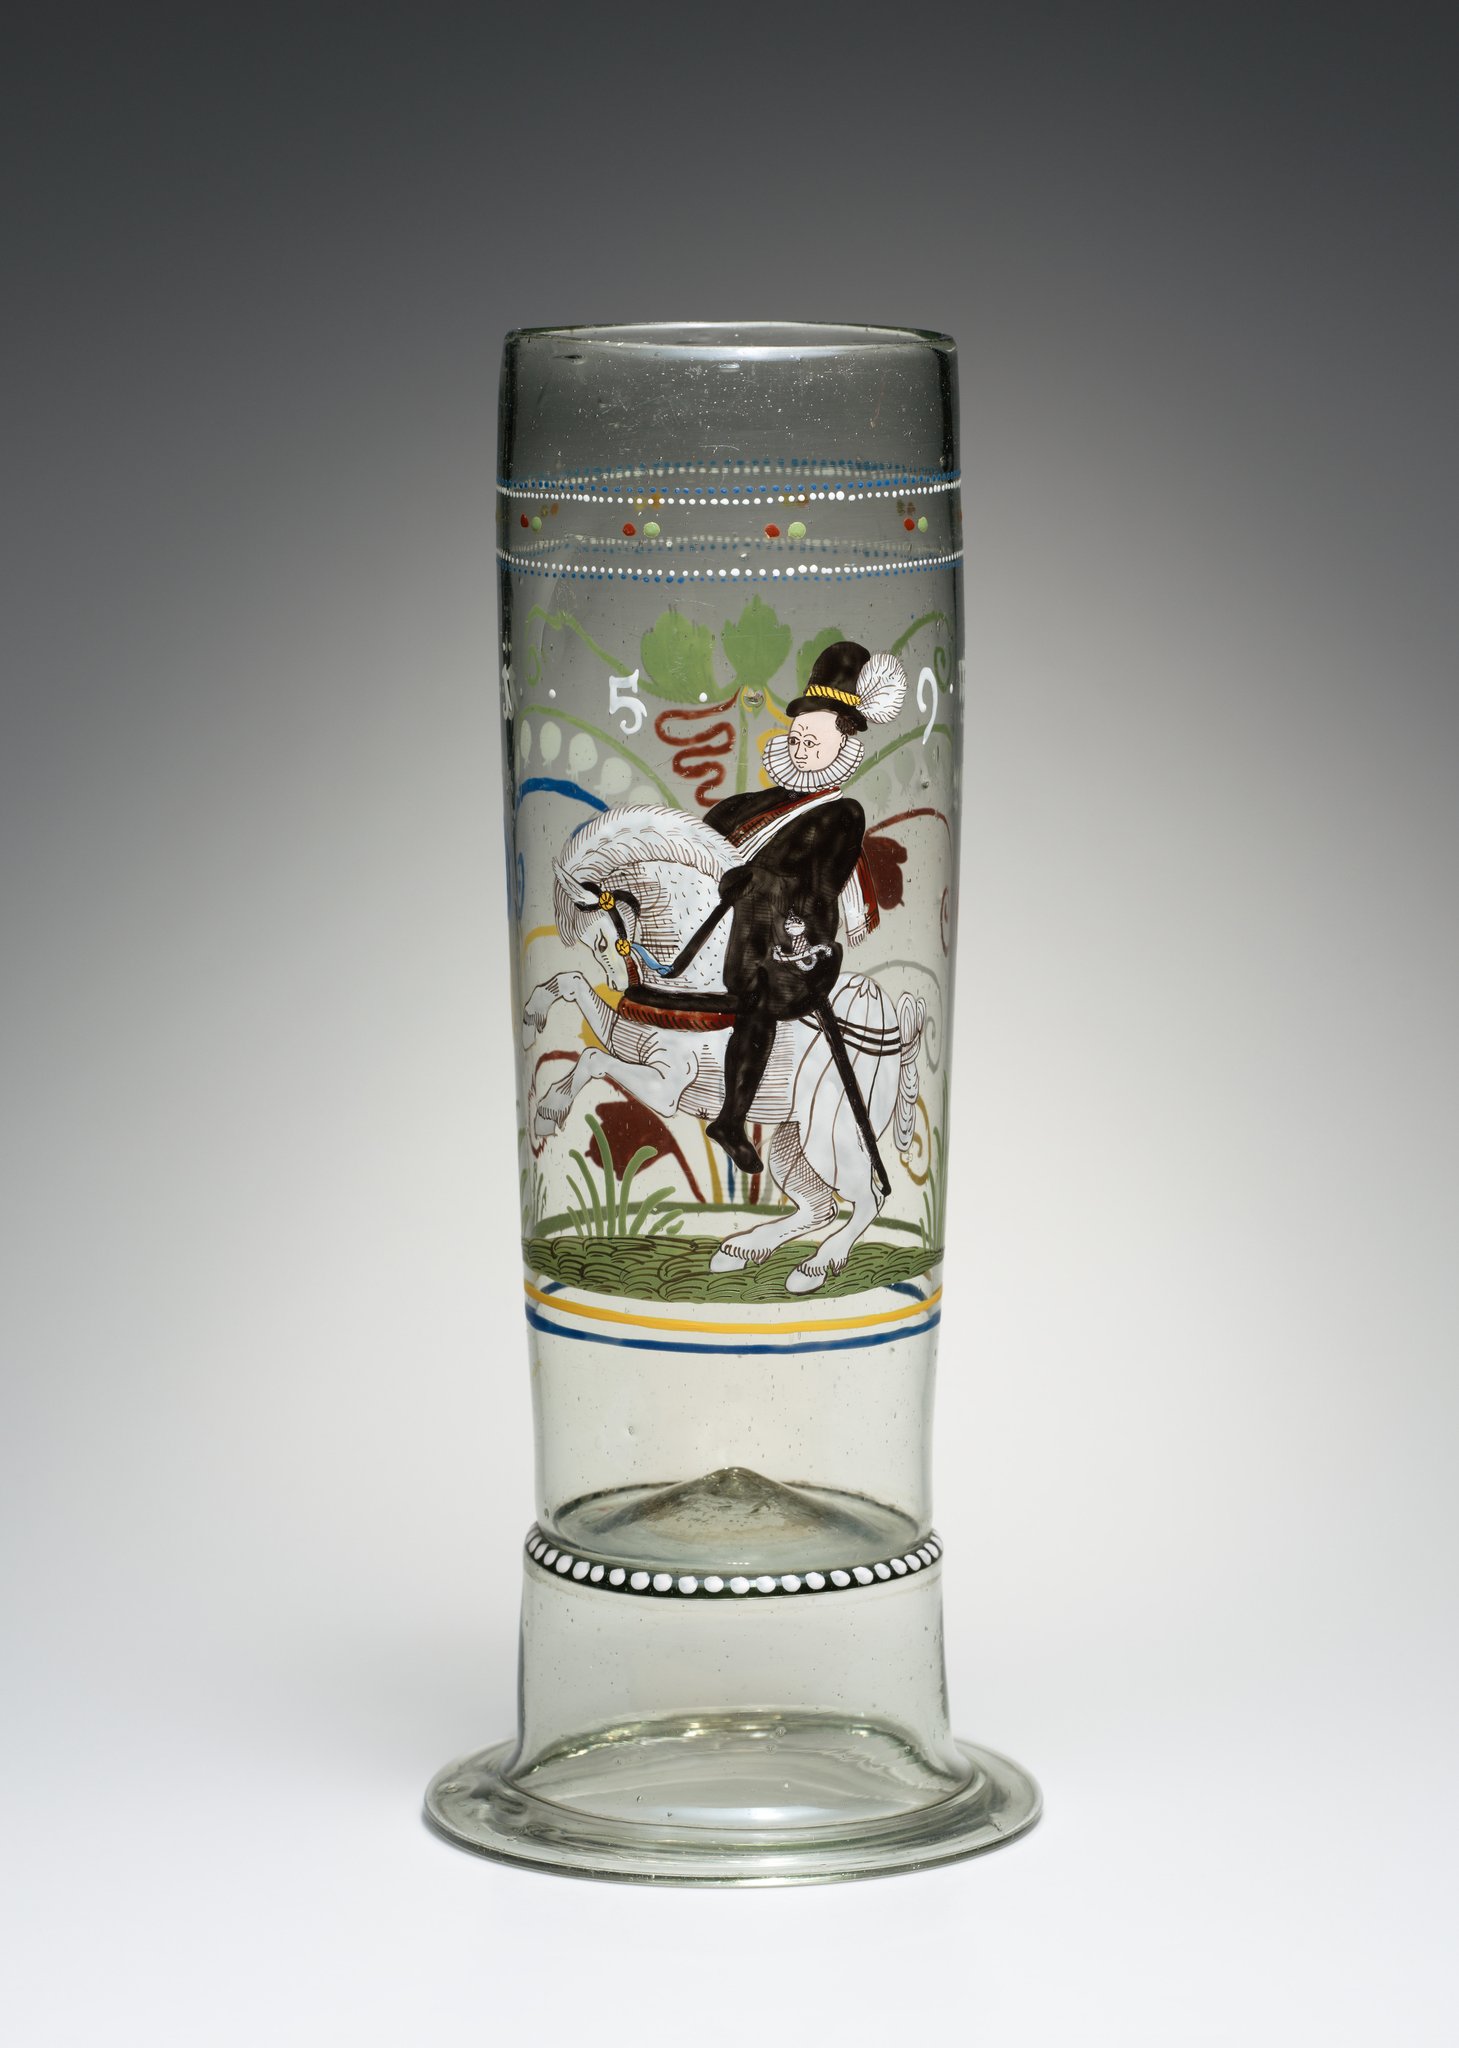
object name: beaker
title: Beaker (Stangenglas)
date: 1595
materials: glass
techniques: enamel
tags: men,horses